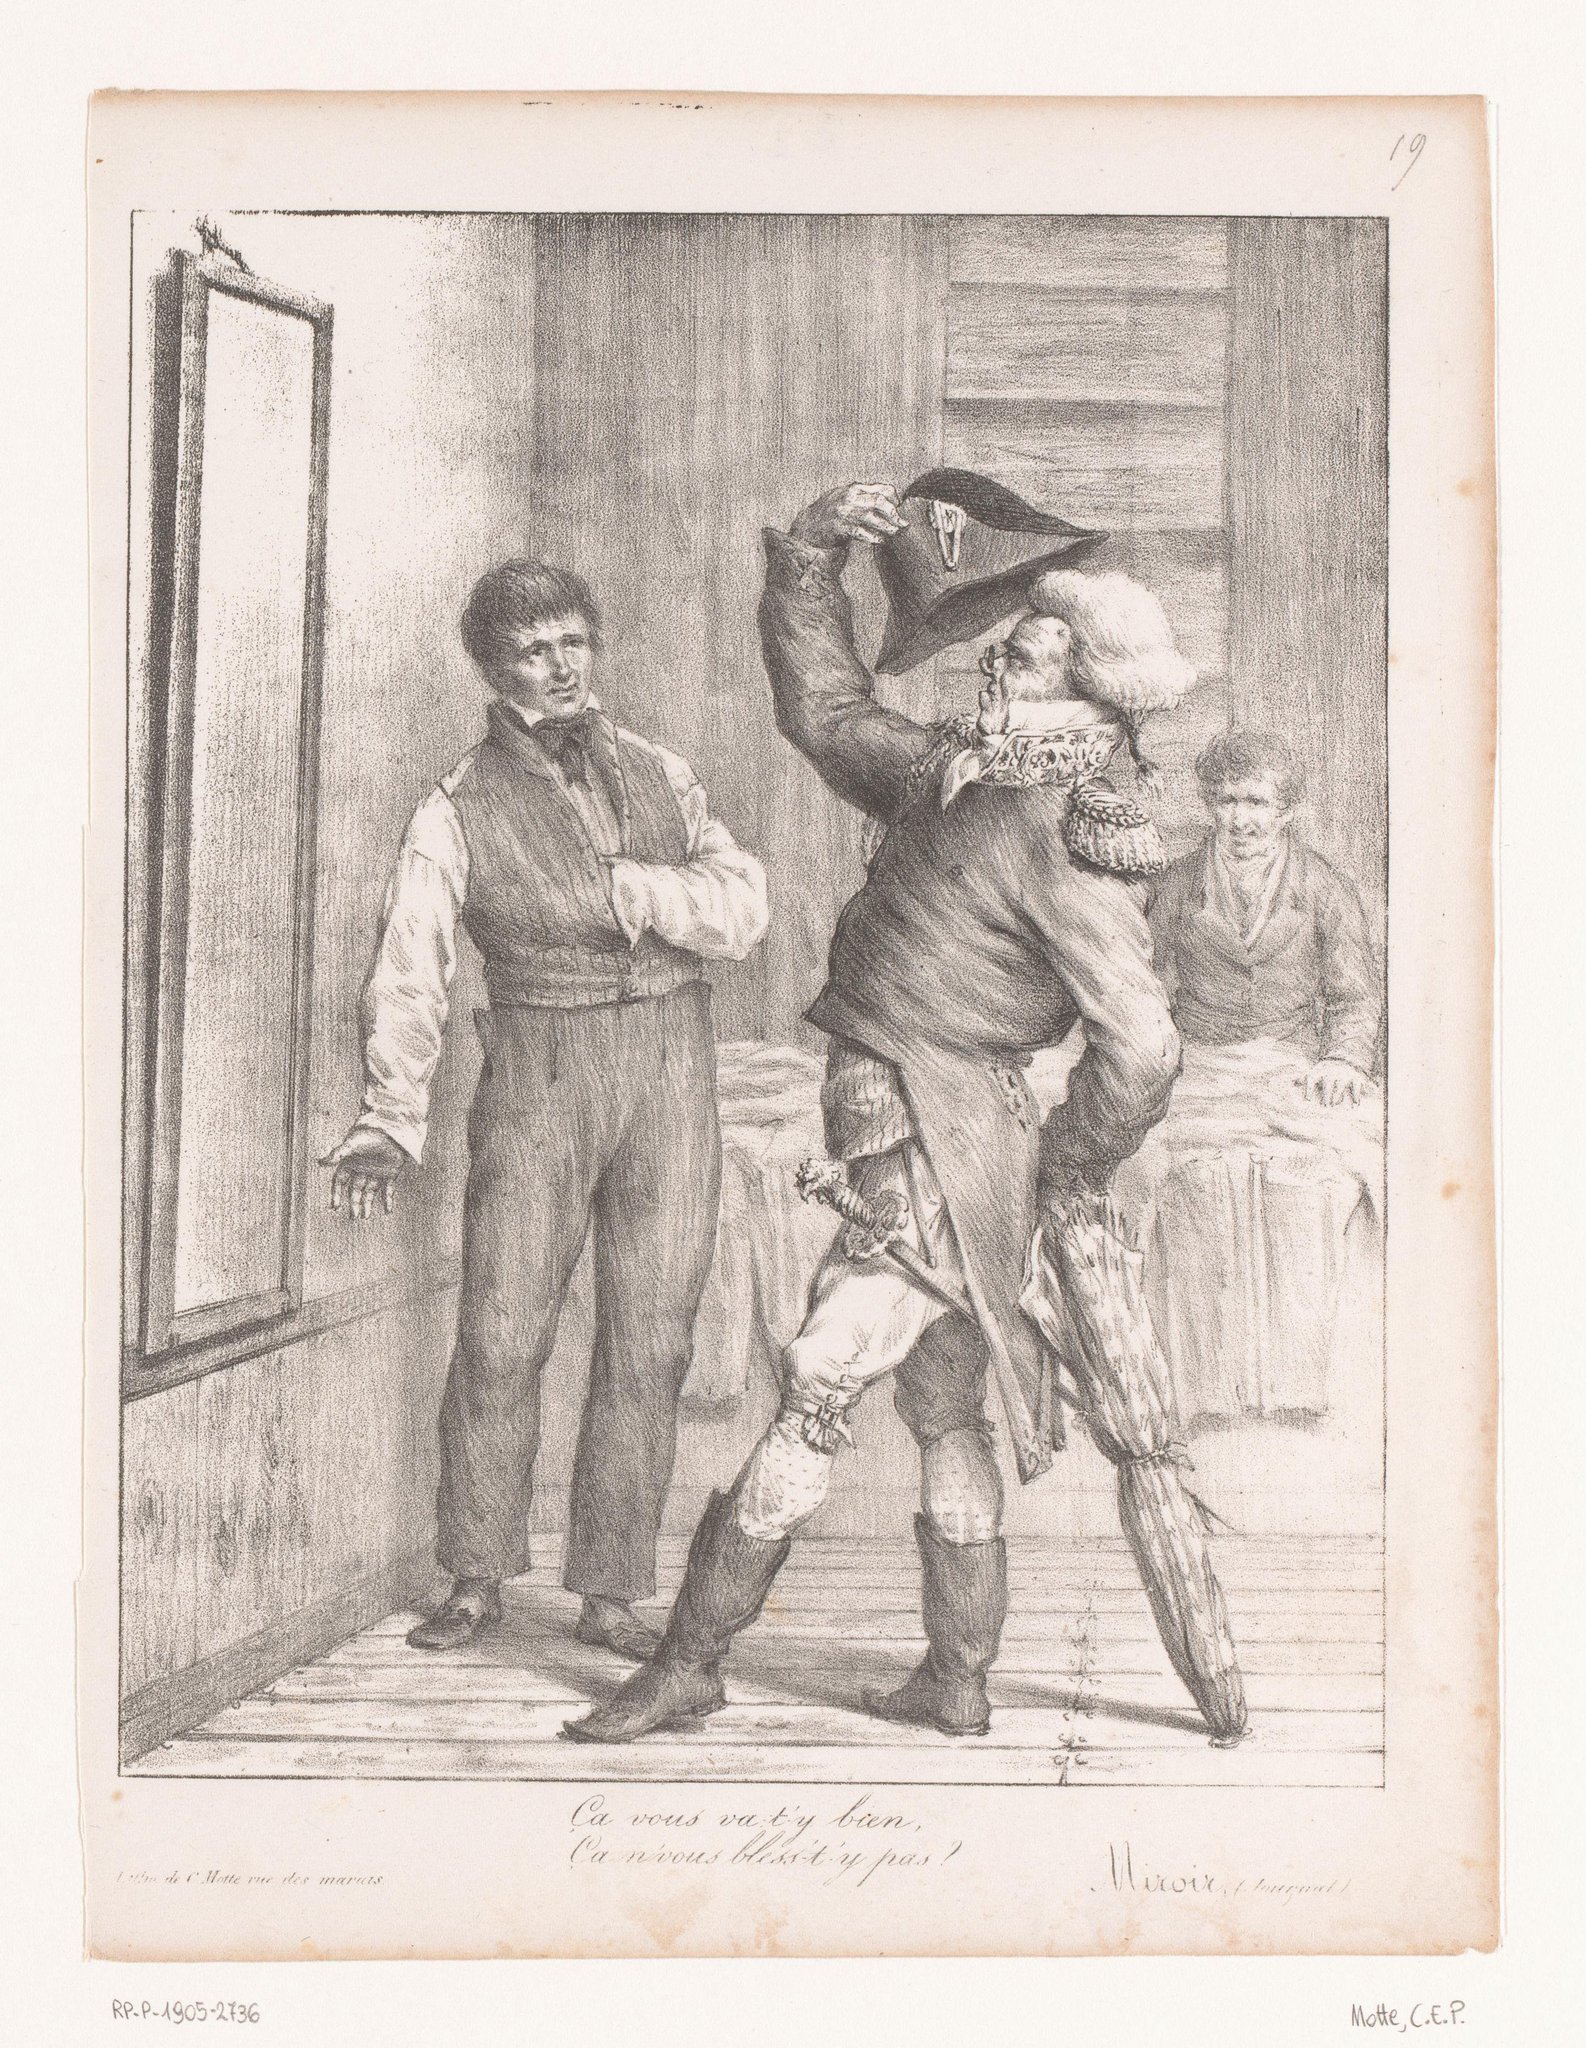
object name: print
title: Ca vous va t'y bien. Ca n'vous blesse-t'-y pas?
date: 1821-1823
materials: paper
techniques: lithograph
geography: paris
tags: head-gear, mirror, (military) uniforms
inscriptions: collector's mark: Lugt 2228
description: Prent gebruikt in: Le Miroir des spectacles, des lettres, des mœurs et des arts, 1821-1823.